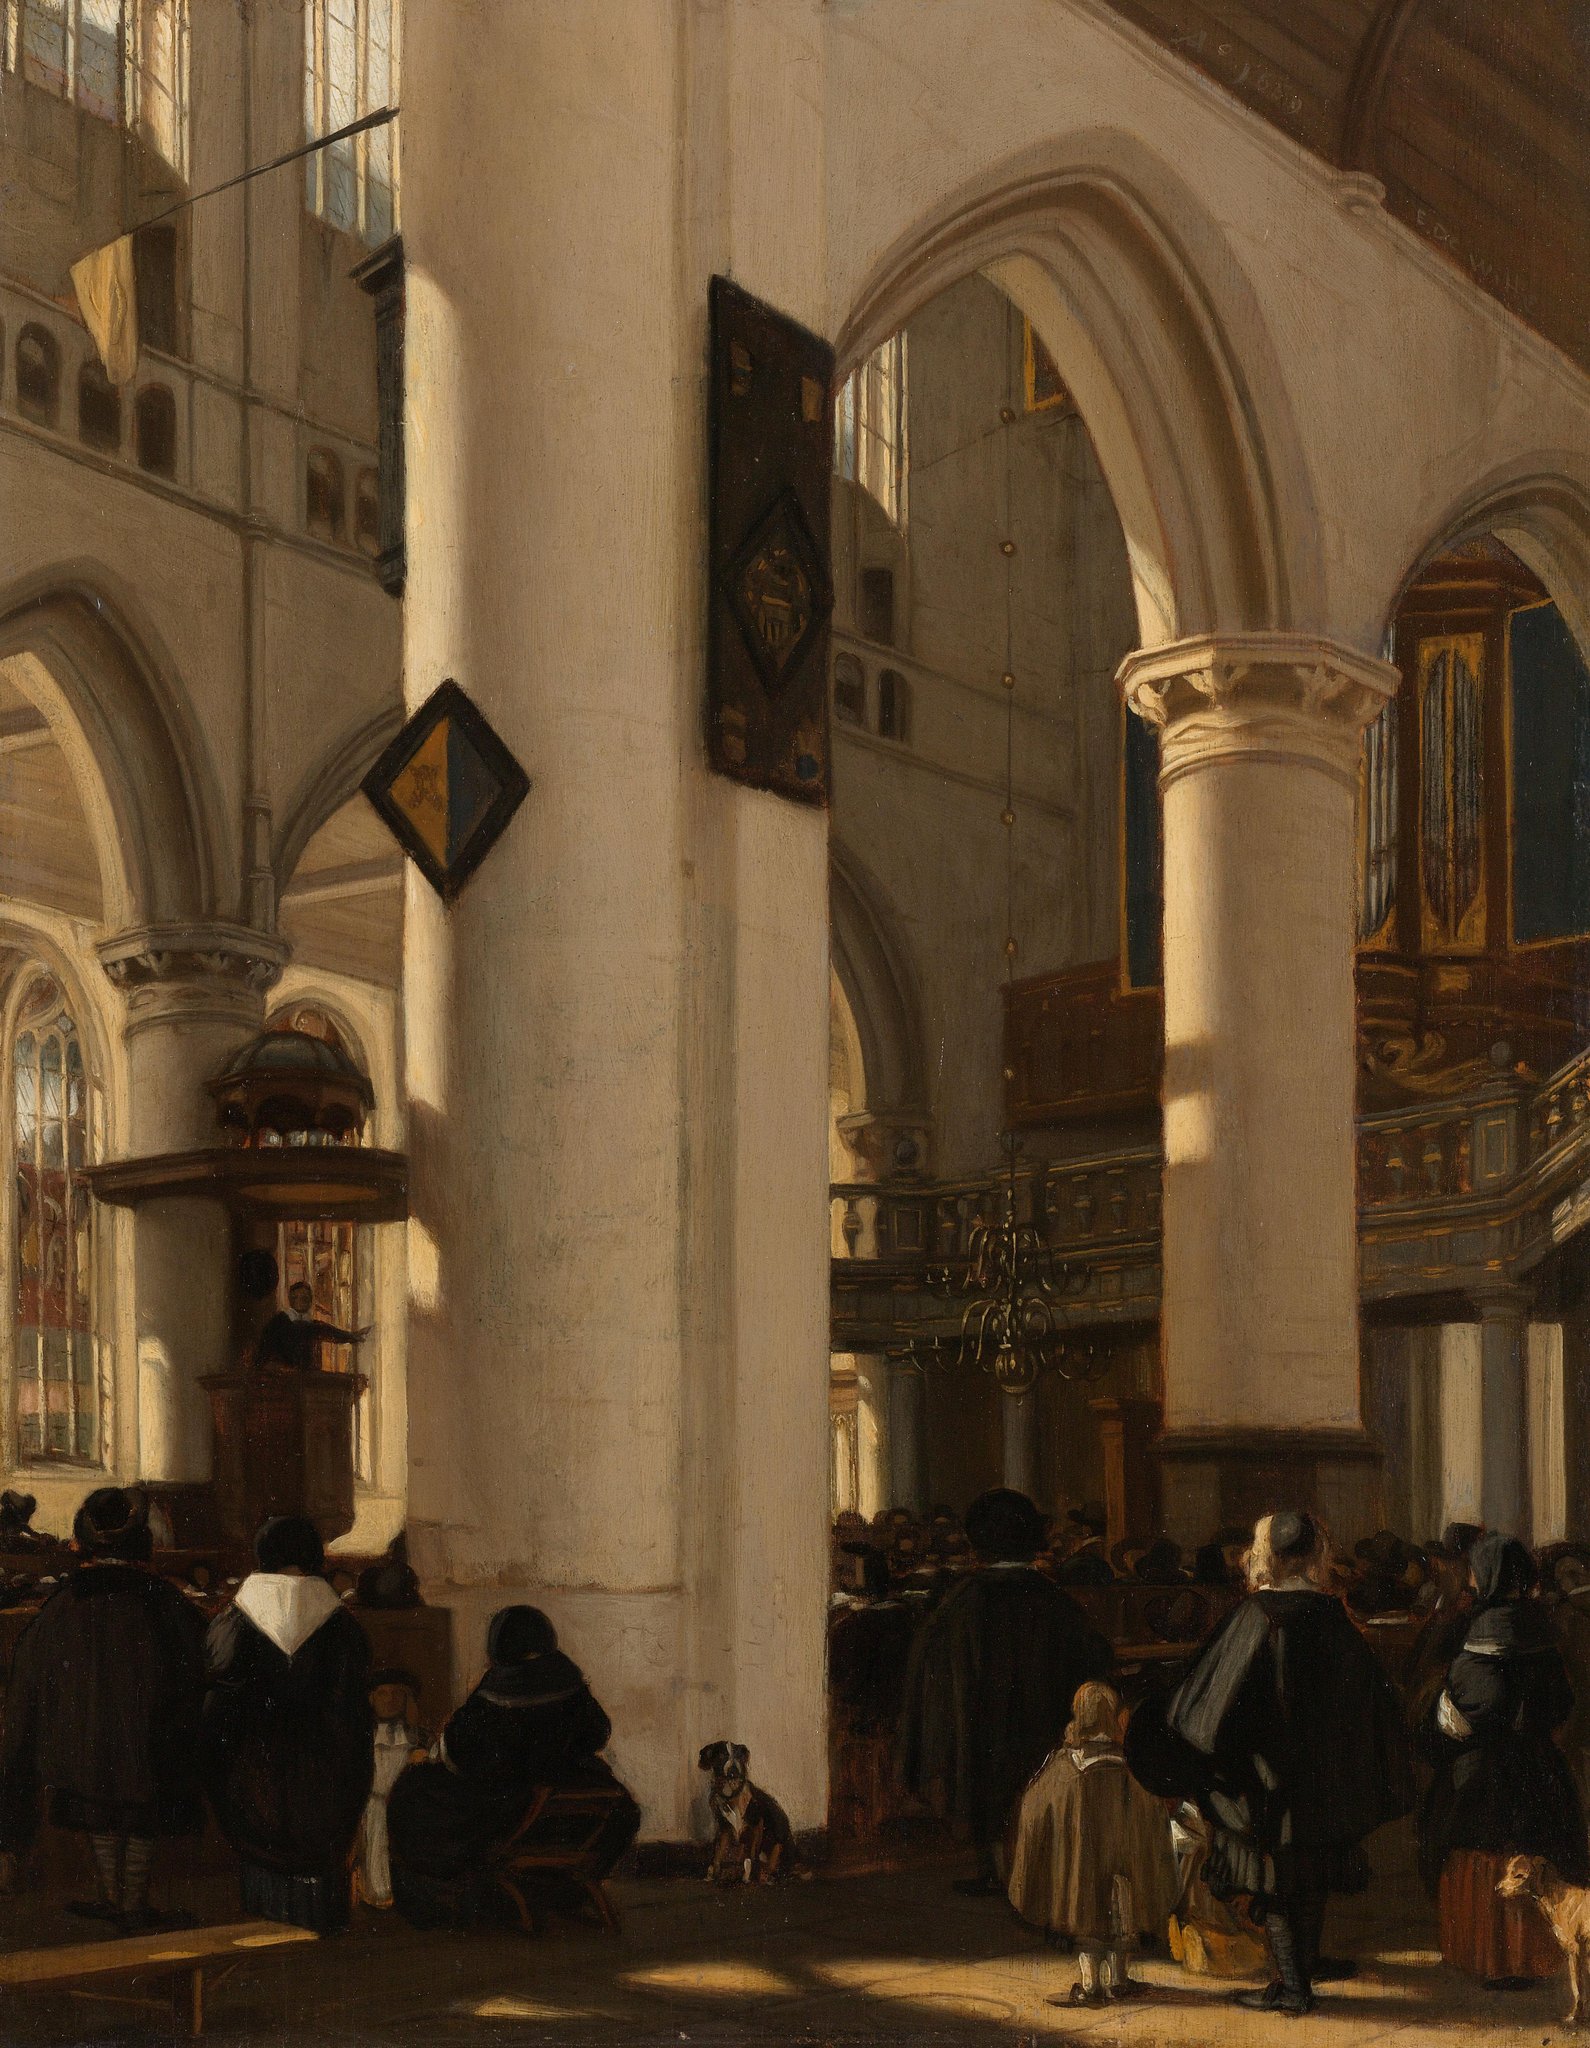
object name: painting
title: Interior of a Protestant, Gothic Church during a Service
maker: emanuel de witte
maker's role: painter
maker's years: 1617-1692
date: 1669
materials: oil, panel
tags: interior of church, sermon ~ protestant service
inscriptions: signature and date: ‘Aº 1669 E. De Witte’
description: However much it might seem as if Emanuel de Witte attended this church service, the painter did not depict reality. In fact, he composed this church interior from parts of various existing churches. The nave, for instance, is based on that of the Oude Kerk in Amsterdam. The emphasis is on perspective and the effects of light and shadow. Thus he was able to create a convincing image.